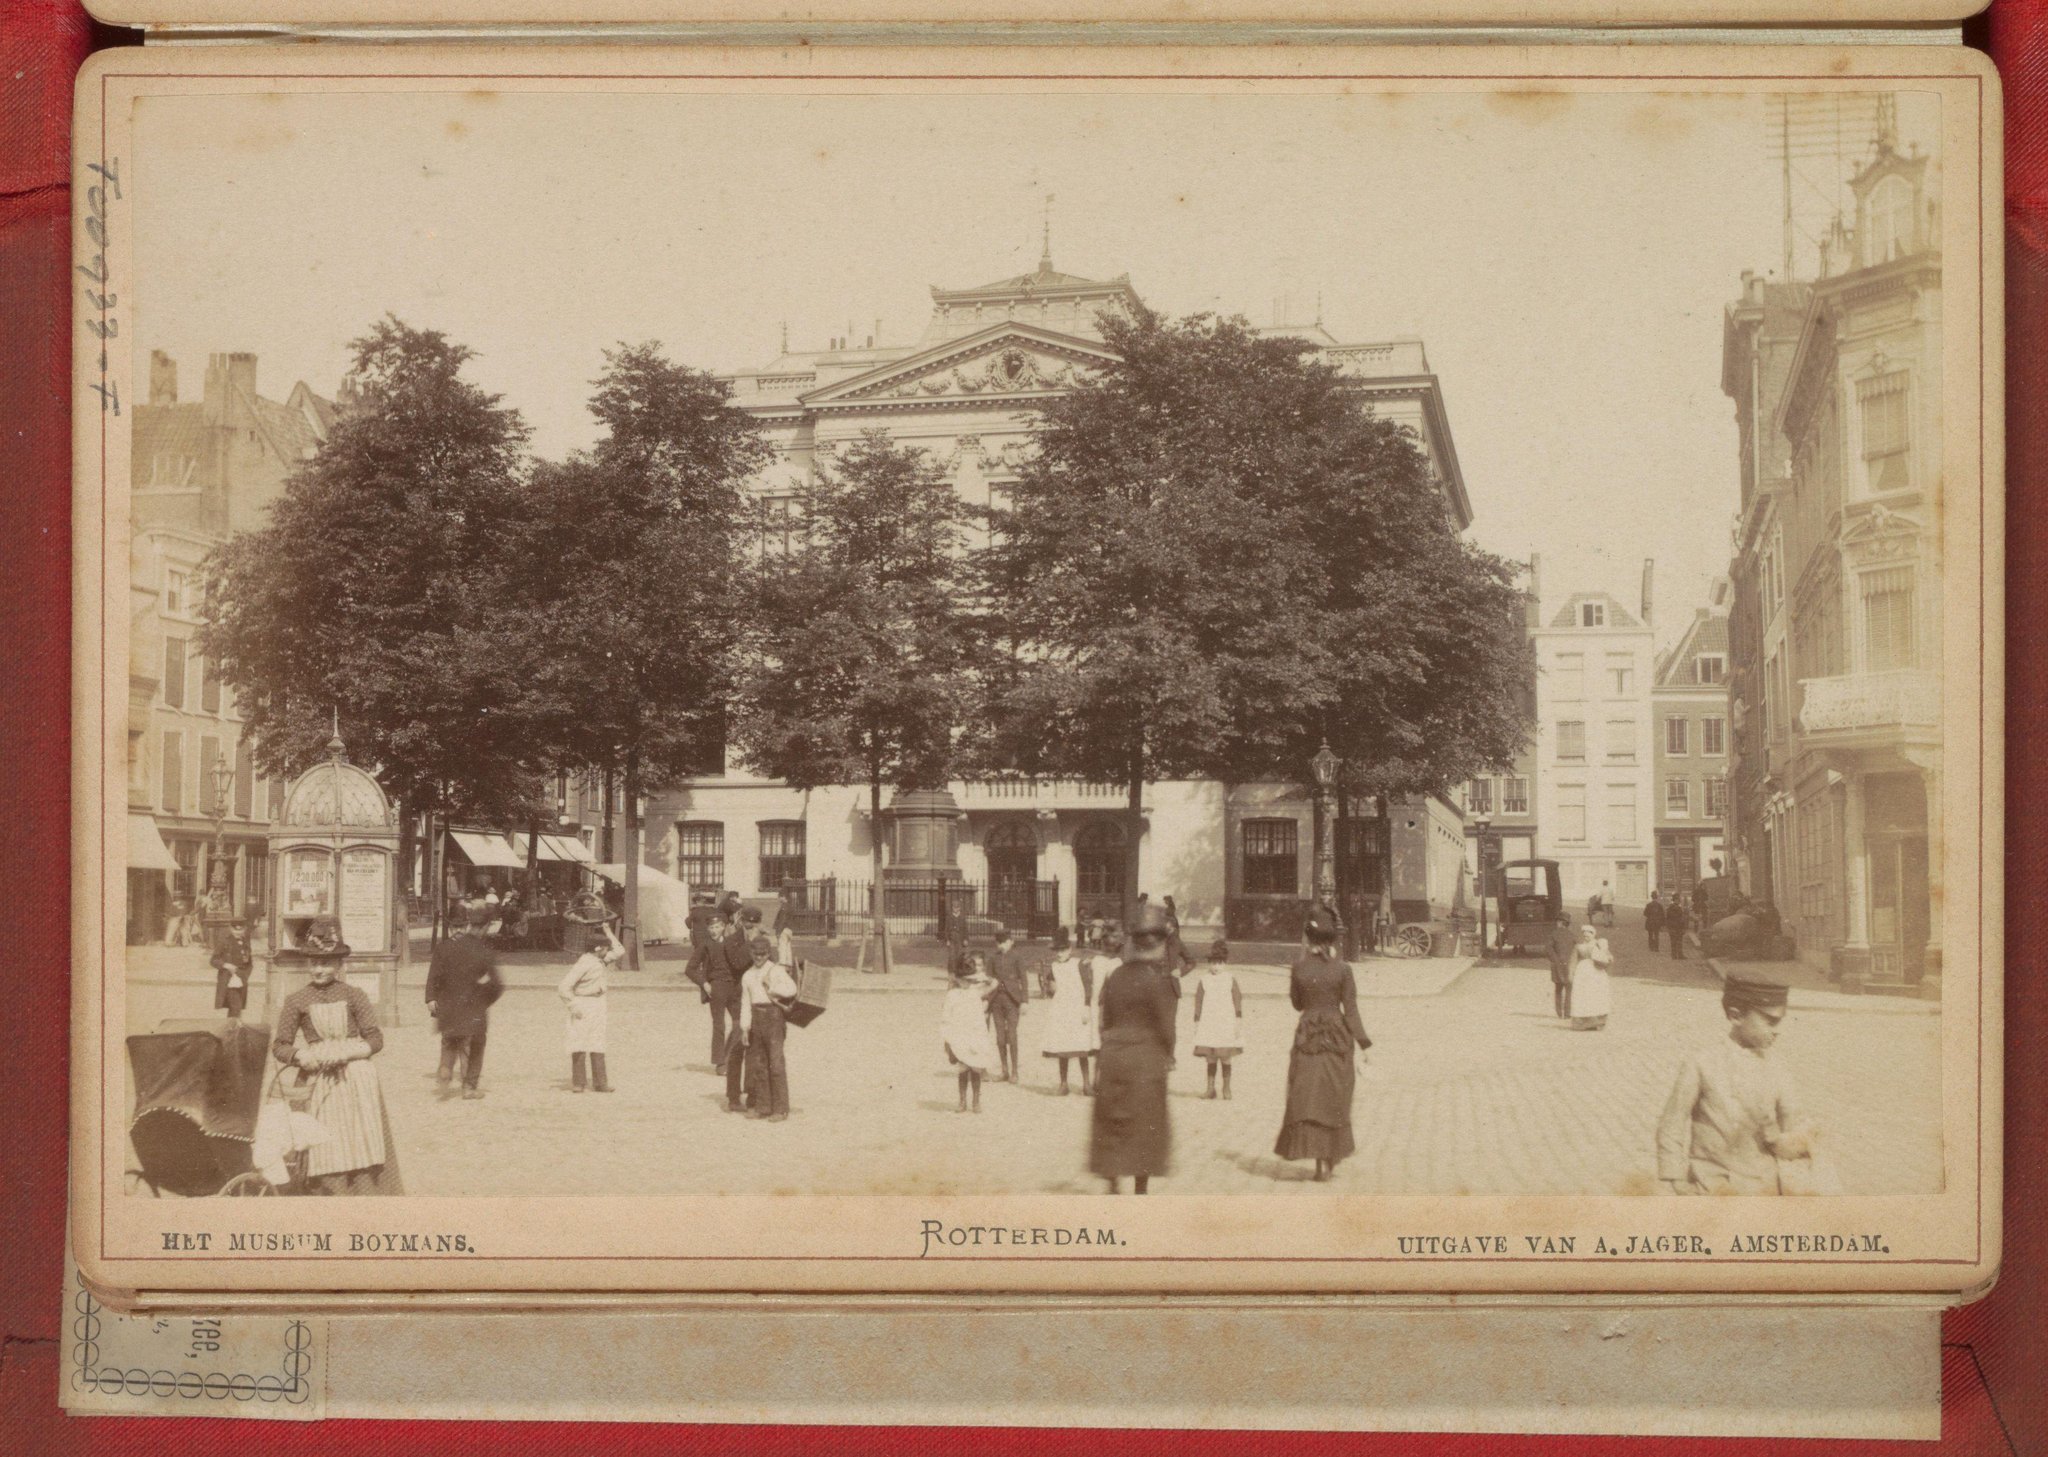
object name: photograph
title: Gezicht op Museum Boymans in het Schielandshuis te Rotterdam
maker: andries jager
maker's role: publisher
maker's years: 1825-1905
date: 1867-1900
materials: cardboard, photographic support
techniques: albumen print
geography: rotterdam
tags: viaduct, railway, train, bridge in village across river, canal, etc.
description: Onderdeel van Leporelloalbum met foto's van Rotterdam.